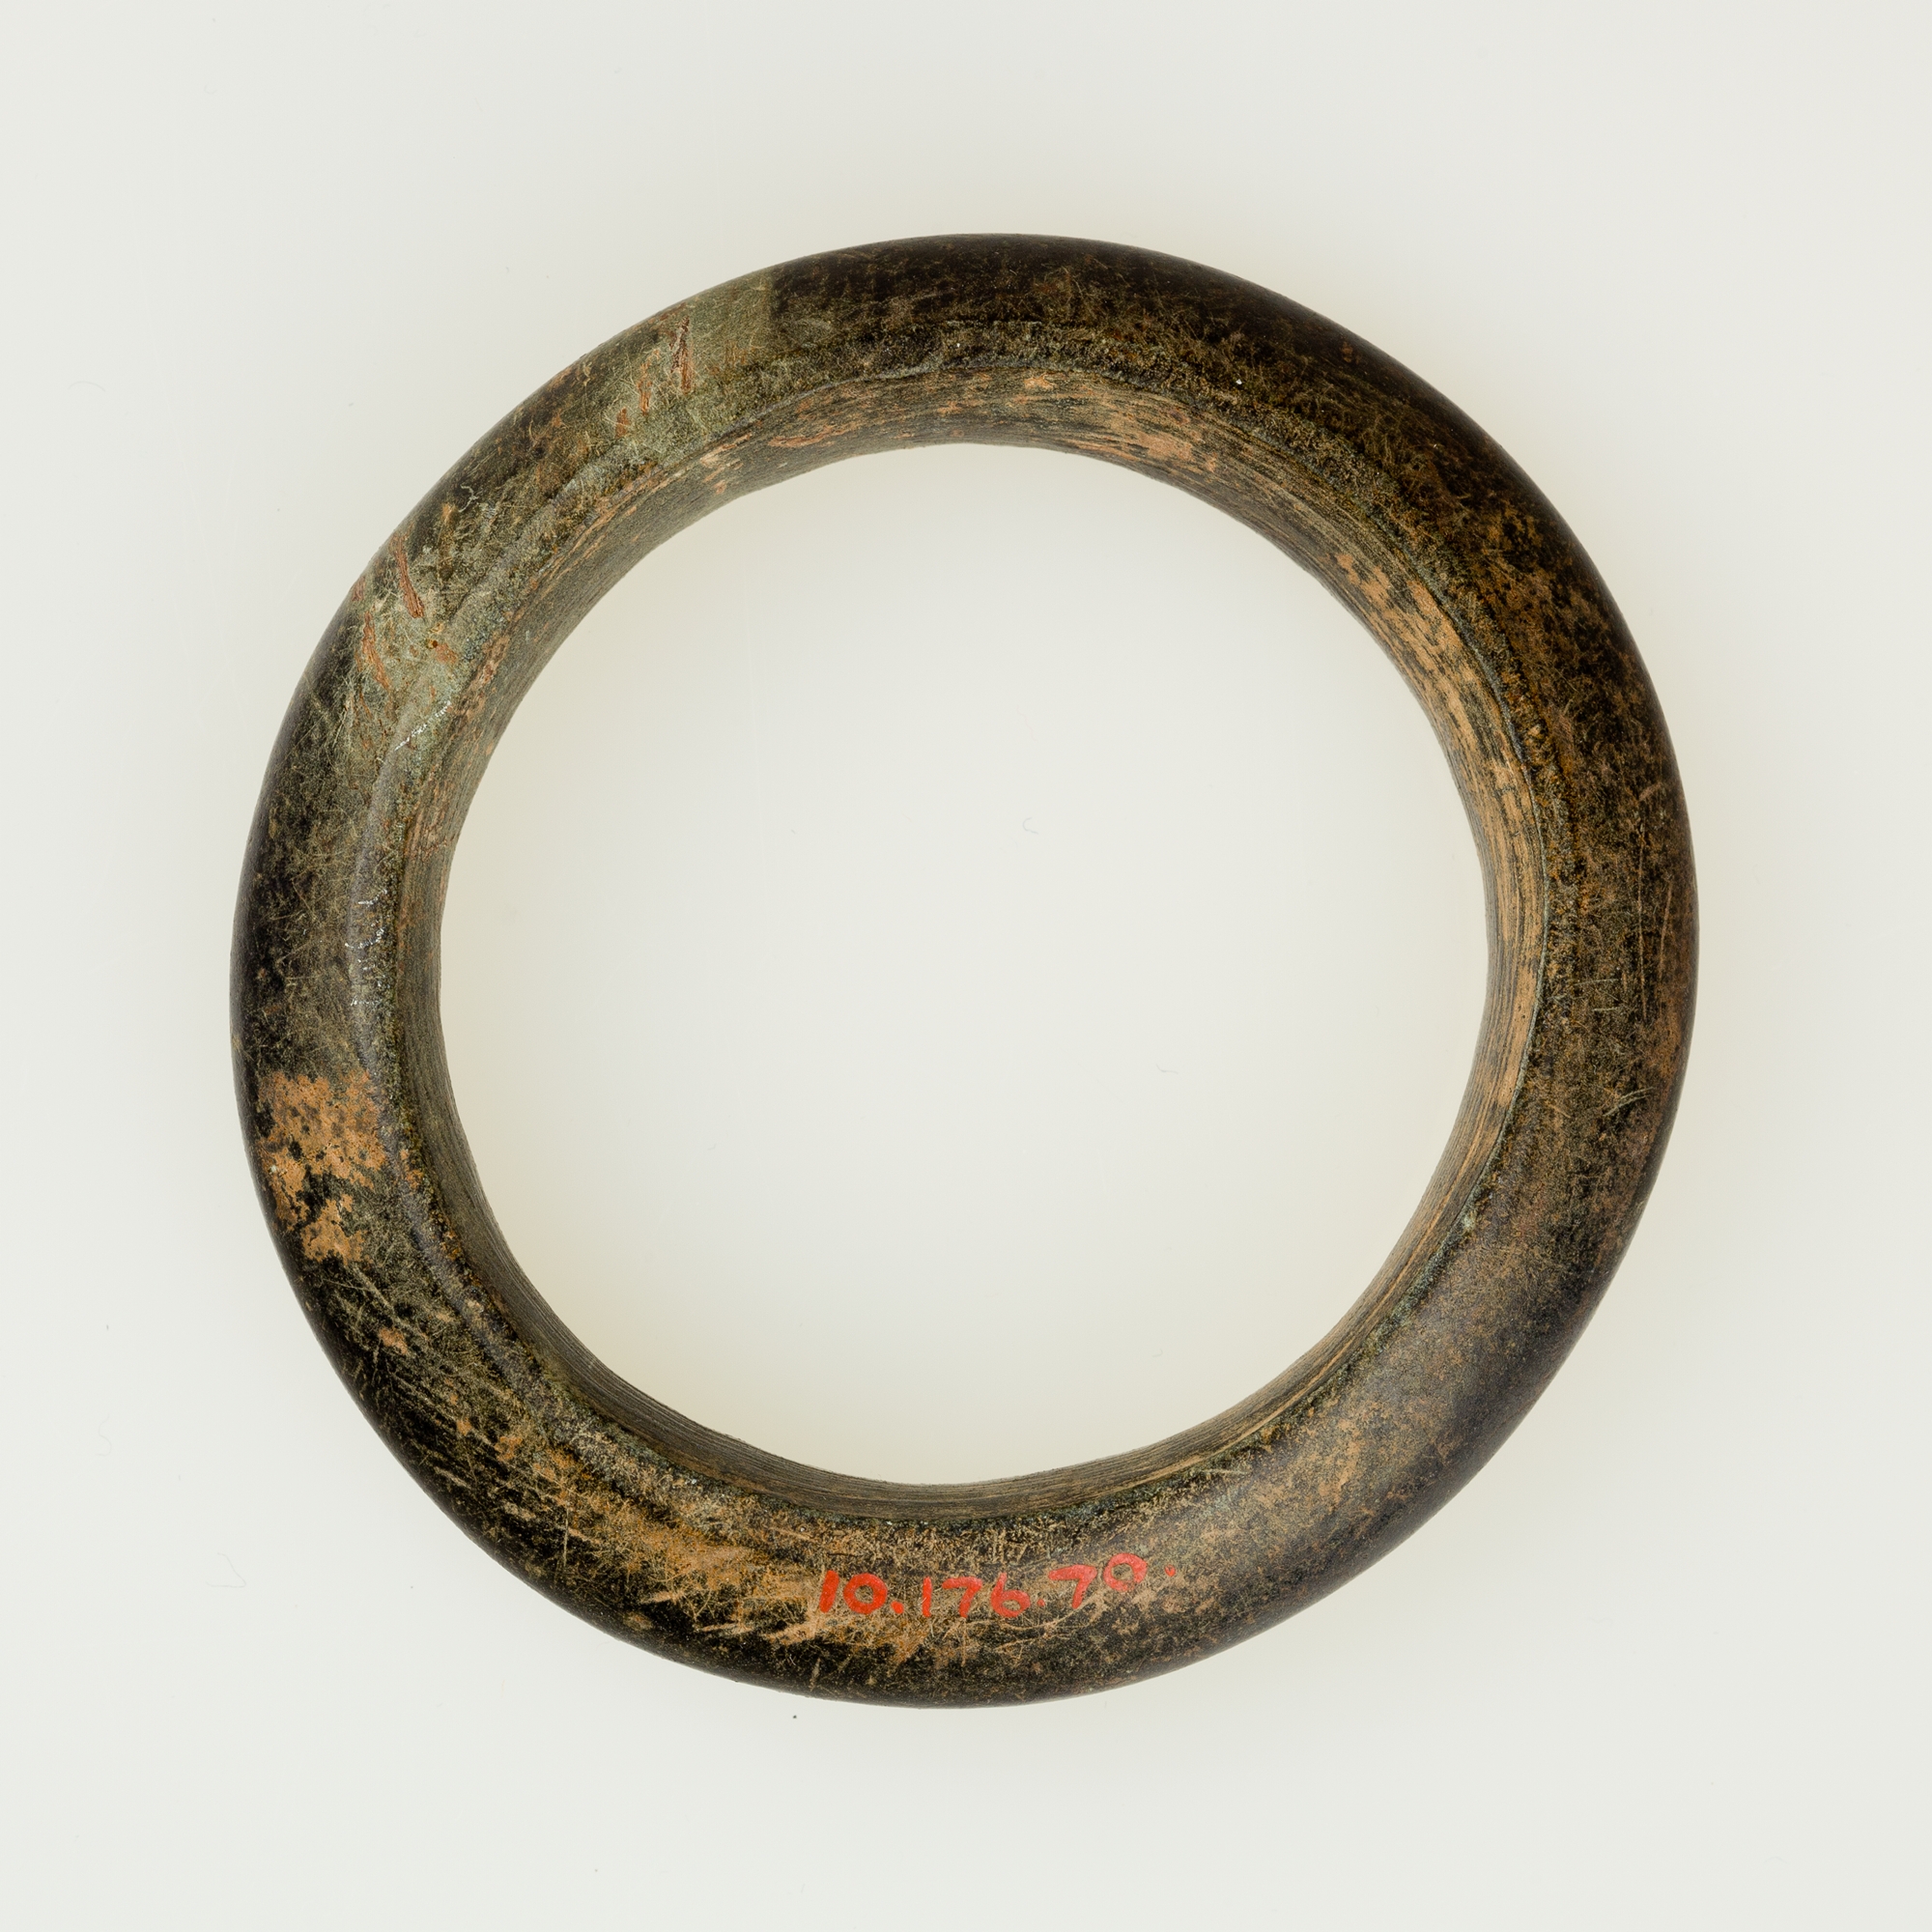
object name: bracelet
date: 3850-2960 BCE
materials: stone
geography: egypt